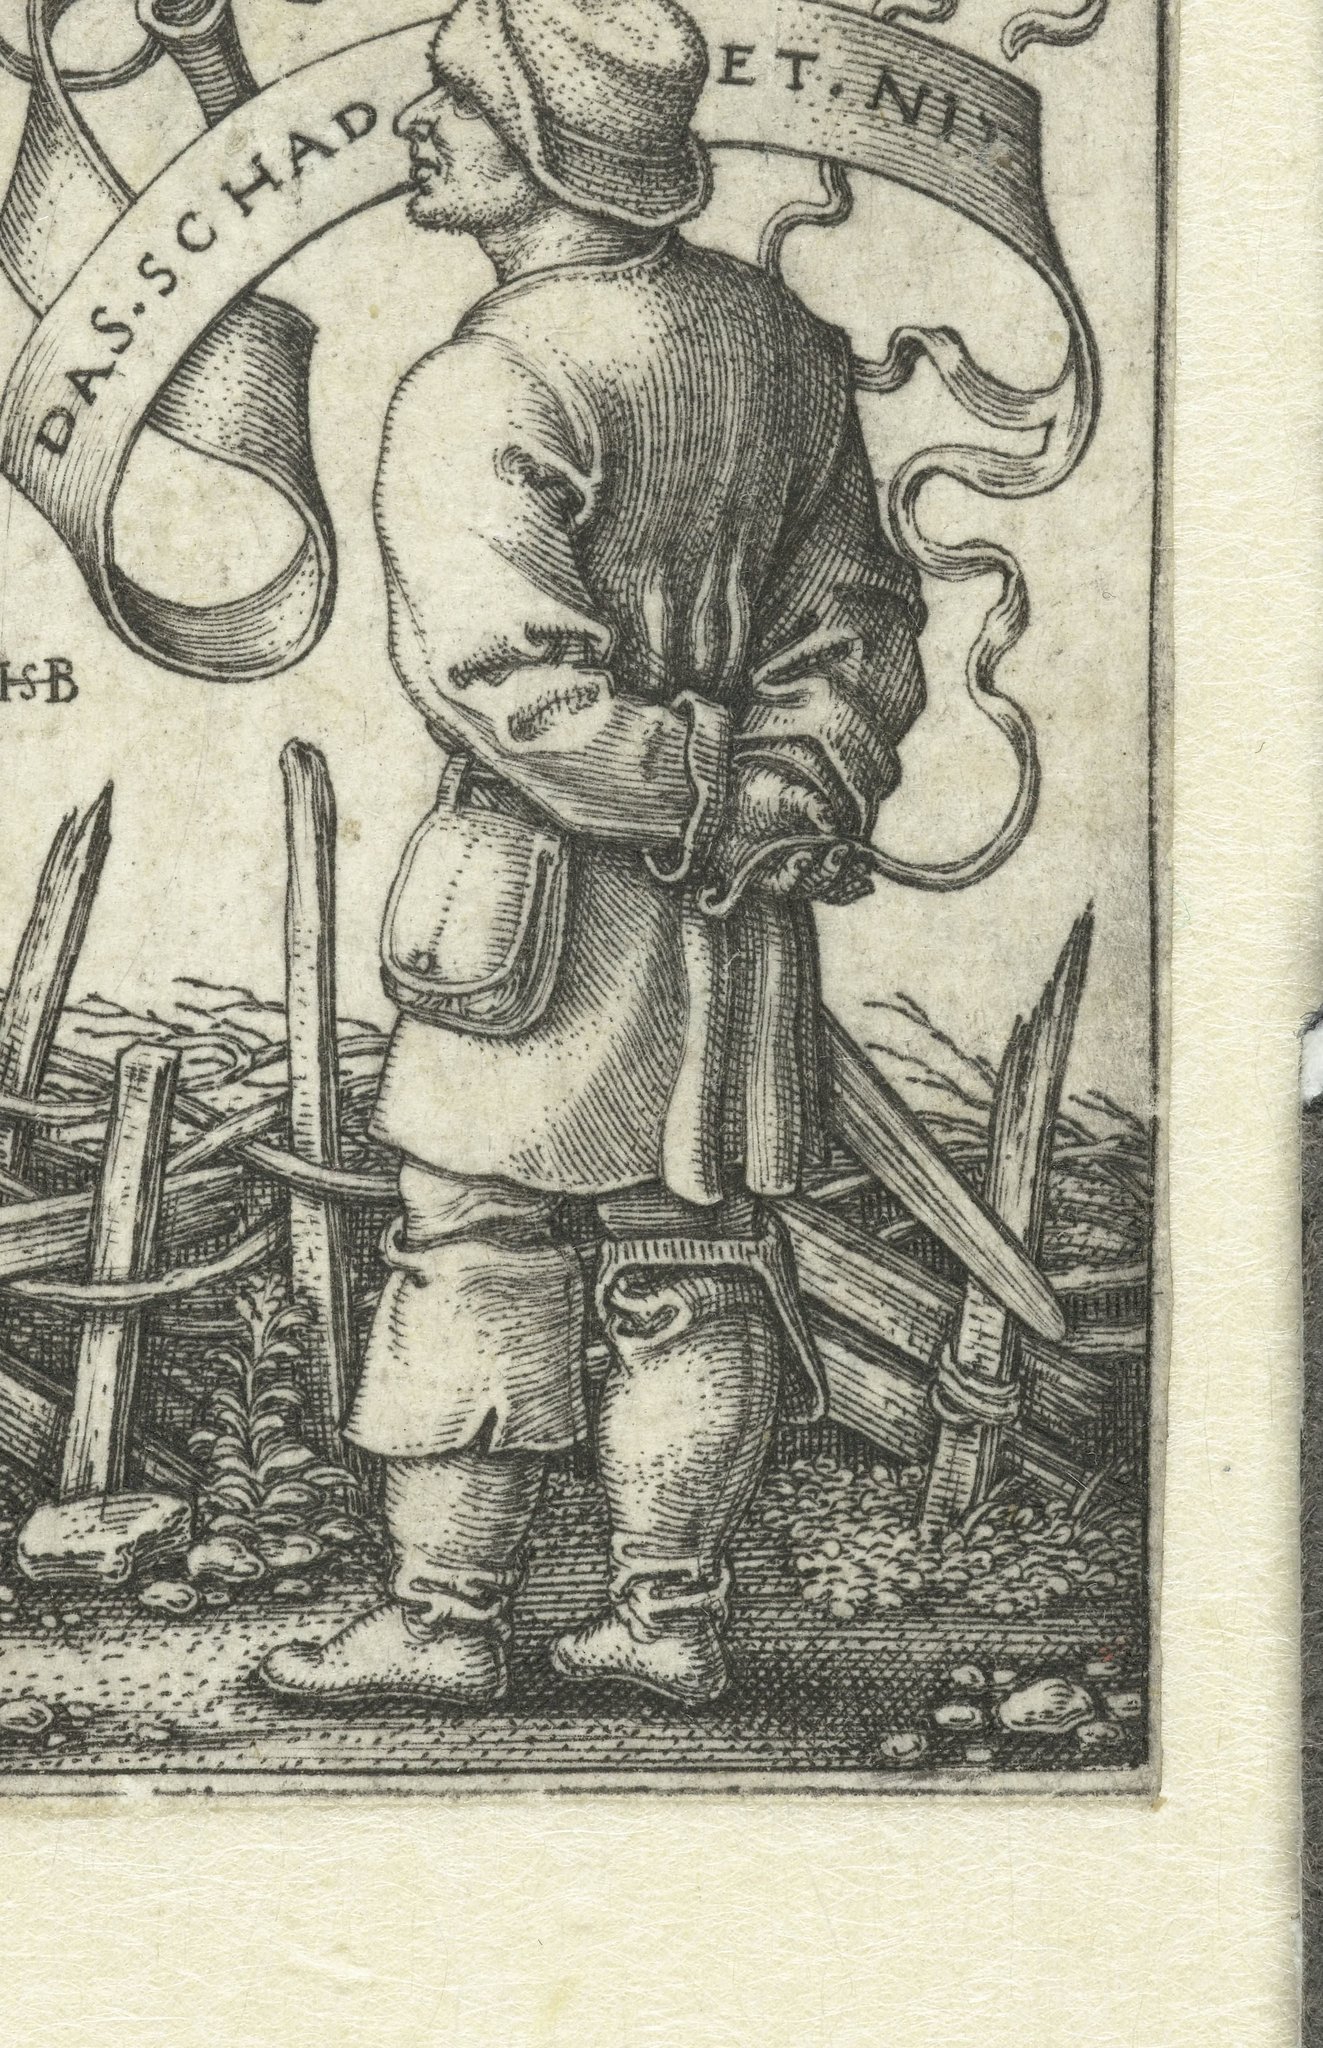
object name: print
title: Das schadet nit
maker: hans sebald beham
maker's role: designer, draughtsman, print maker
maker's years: 1500-1550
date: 1542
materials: paper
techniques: engraving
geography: frankfurt am main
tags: farmers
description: Dit prentje met een boer die naar het weer kijkt en met de handen op de rug vaststelt dat het koude weer geen problemen met zich meebrengt, heeft een pendant met een andere boer met een mestvork in zijn hand. De figuren zijn naar elkaar toegewend weergegeven met de titels op tekstbanden welke volledig geïntegreerd zijn met de figuren en hun attributen. De teksten vullen elkaar aan en zijn moralistisch bedoeld, de boer staat hier symbool voor luiheid: het is koud dus hij hoeft niet te werken.